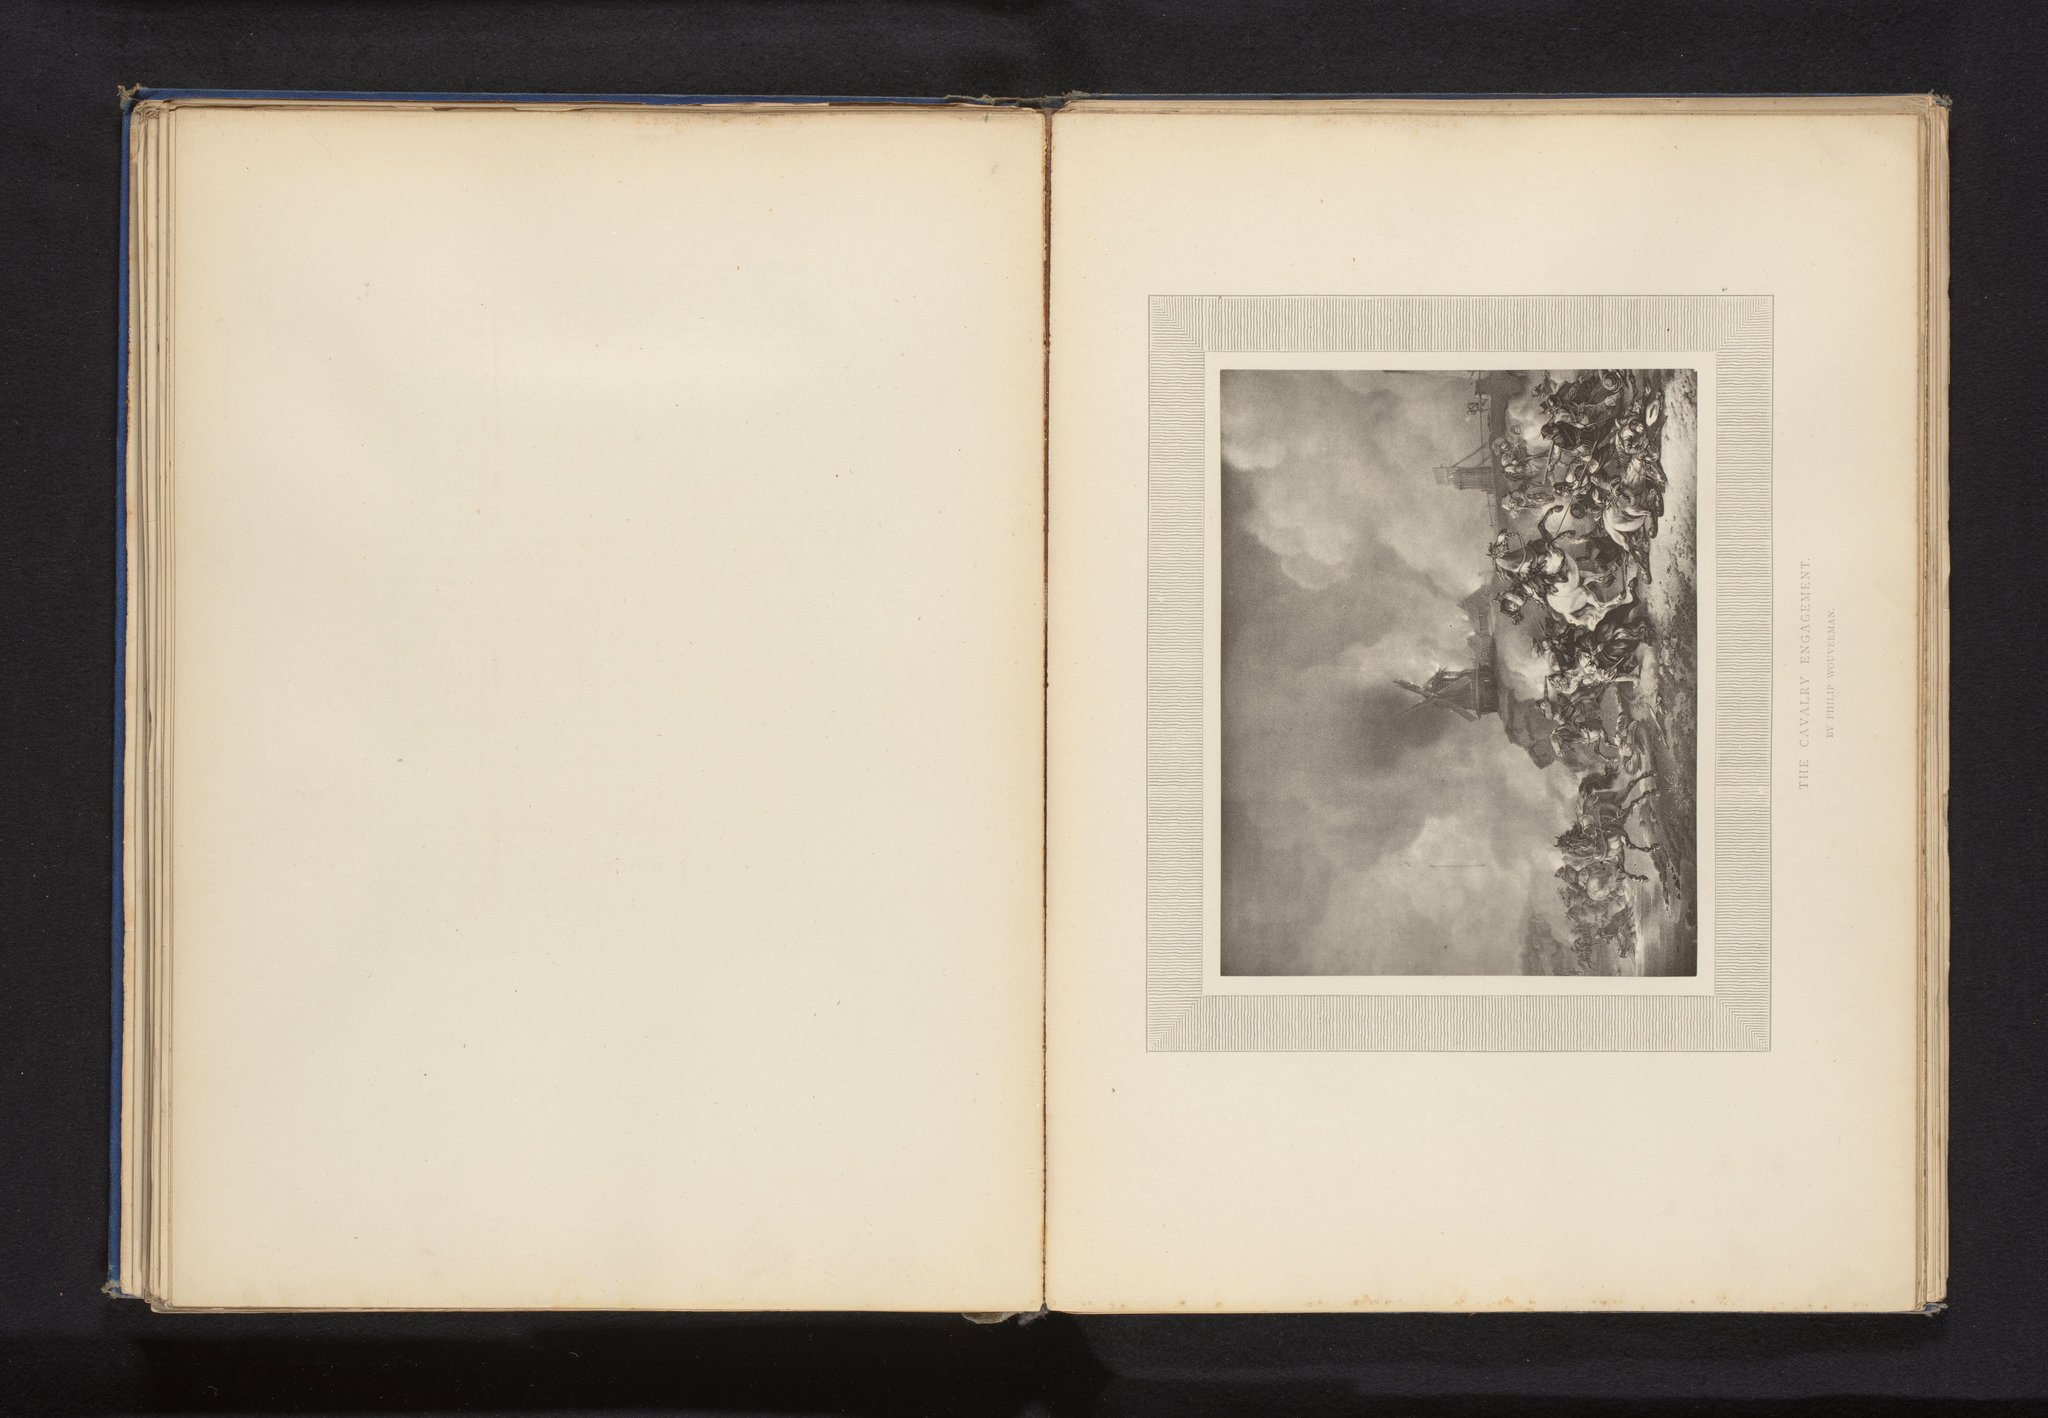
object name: photomechanical print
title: Reproductie van een prent van een slagveld met cavalerie naar Philips Wouwerman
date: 1870-1875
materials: paper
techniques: woodburytype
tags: battle (+ cavalry, horsemen)